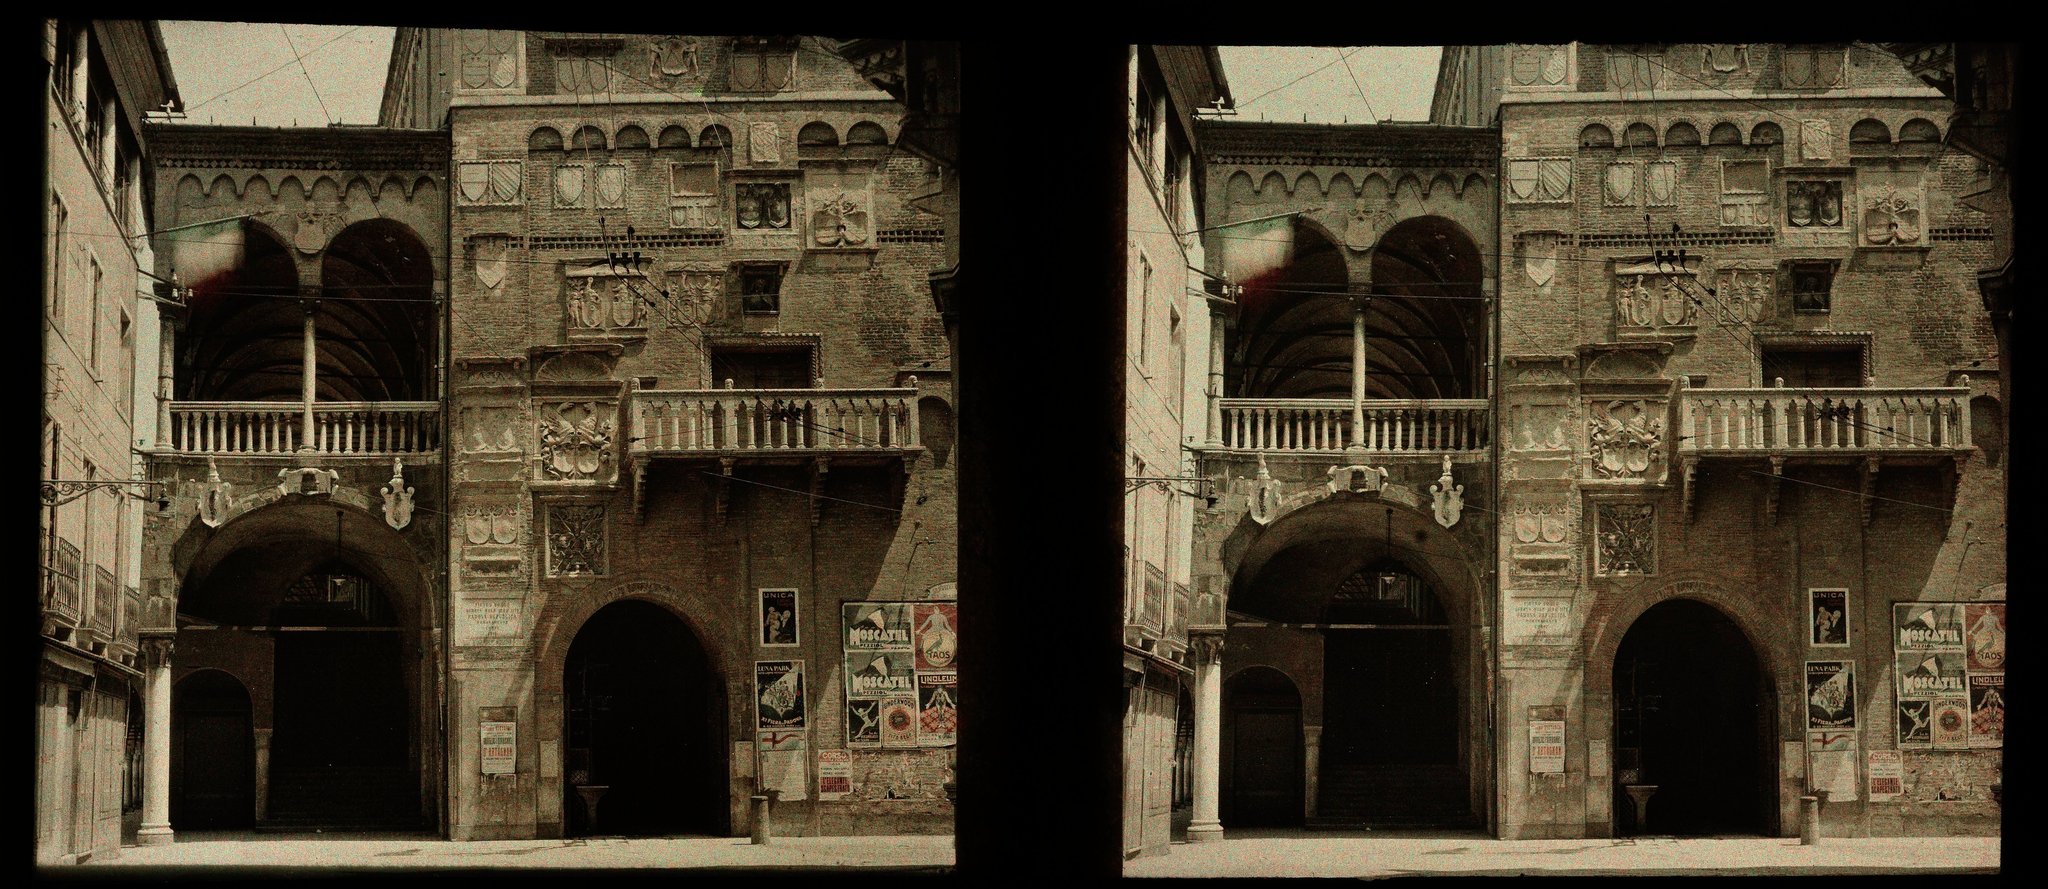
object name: color slide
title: Gezicht op het Palazzo della Ragione, Padua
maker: Anonymous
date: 1907-1930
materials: glass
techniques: autochrome process, slide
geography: italy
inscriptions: annotation: ‘13H / f [?] 8 / 4" / Padove / Palais de / la Razione / [in potlood:] 228’